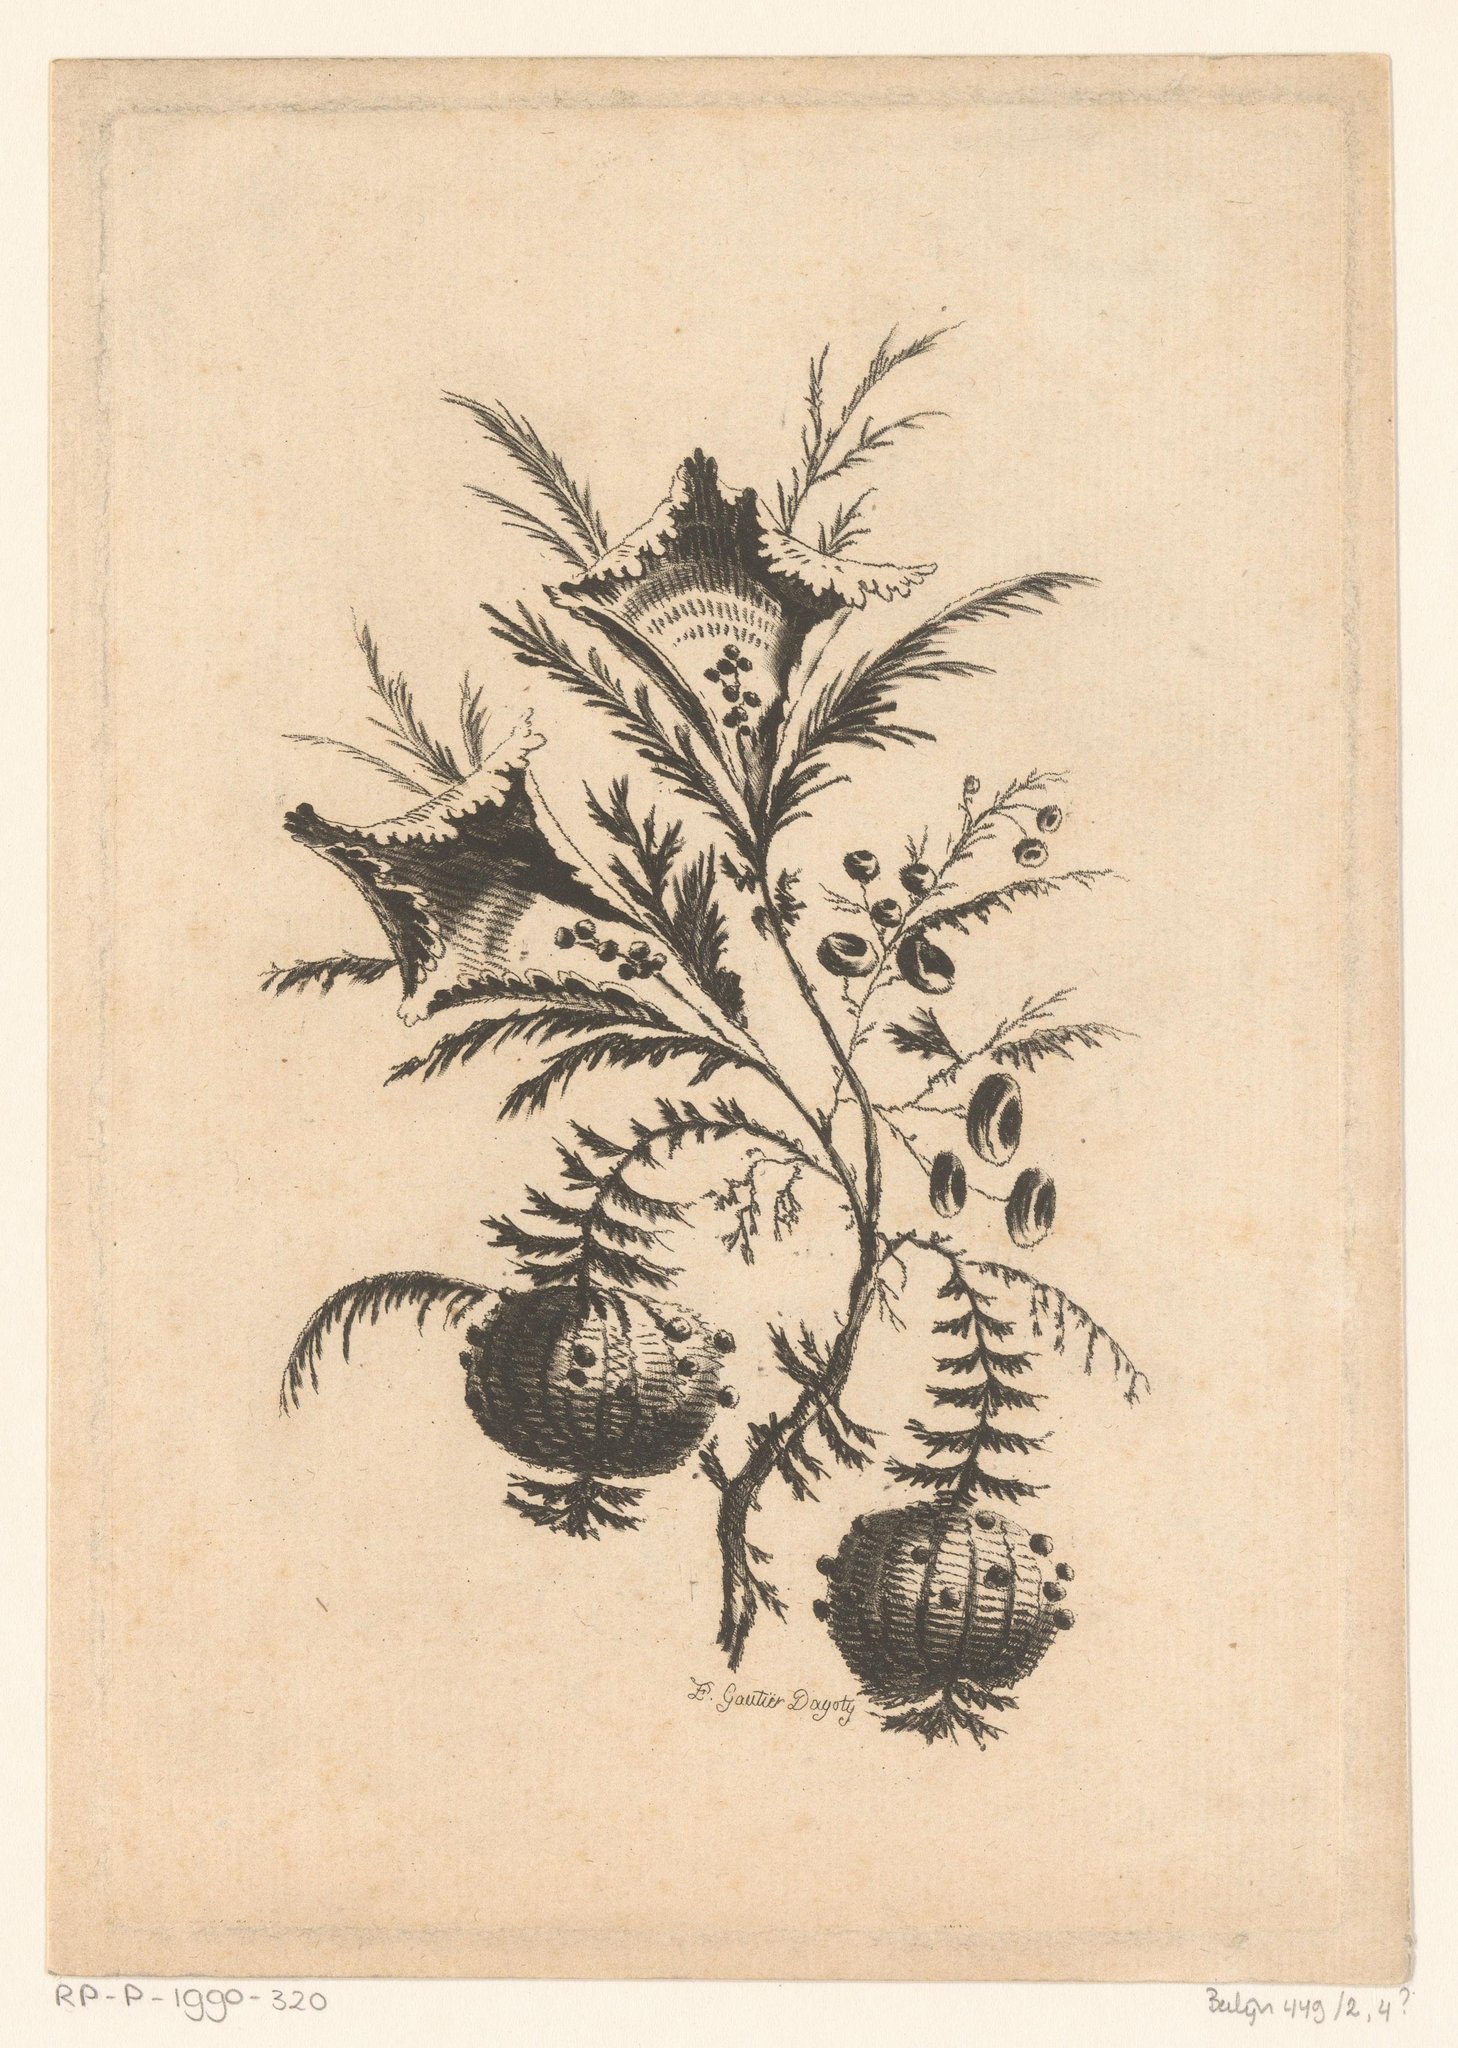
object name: ornament print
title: Fantasiebloemen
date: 1765-1775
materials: paper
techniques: etching, roulette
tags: flowers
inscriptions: collector's mark: Lugt 2228, collector's mark: Lugt 2760